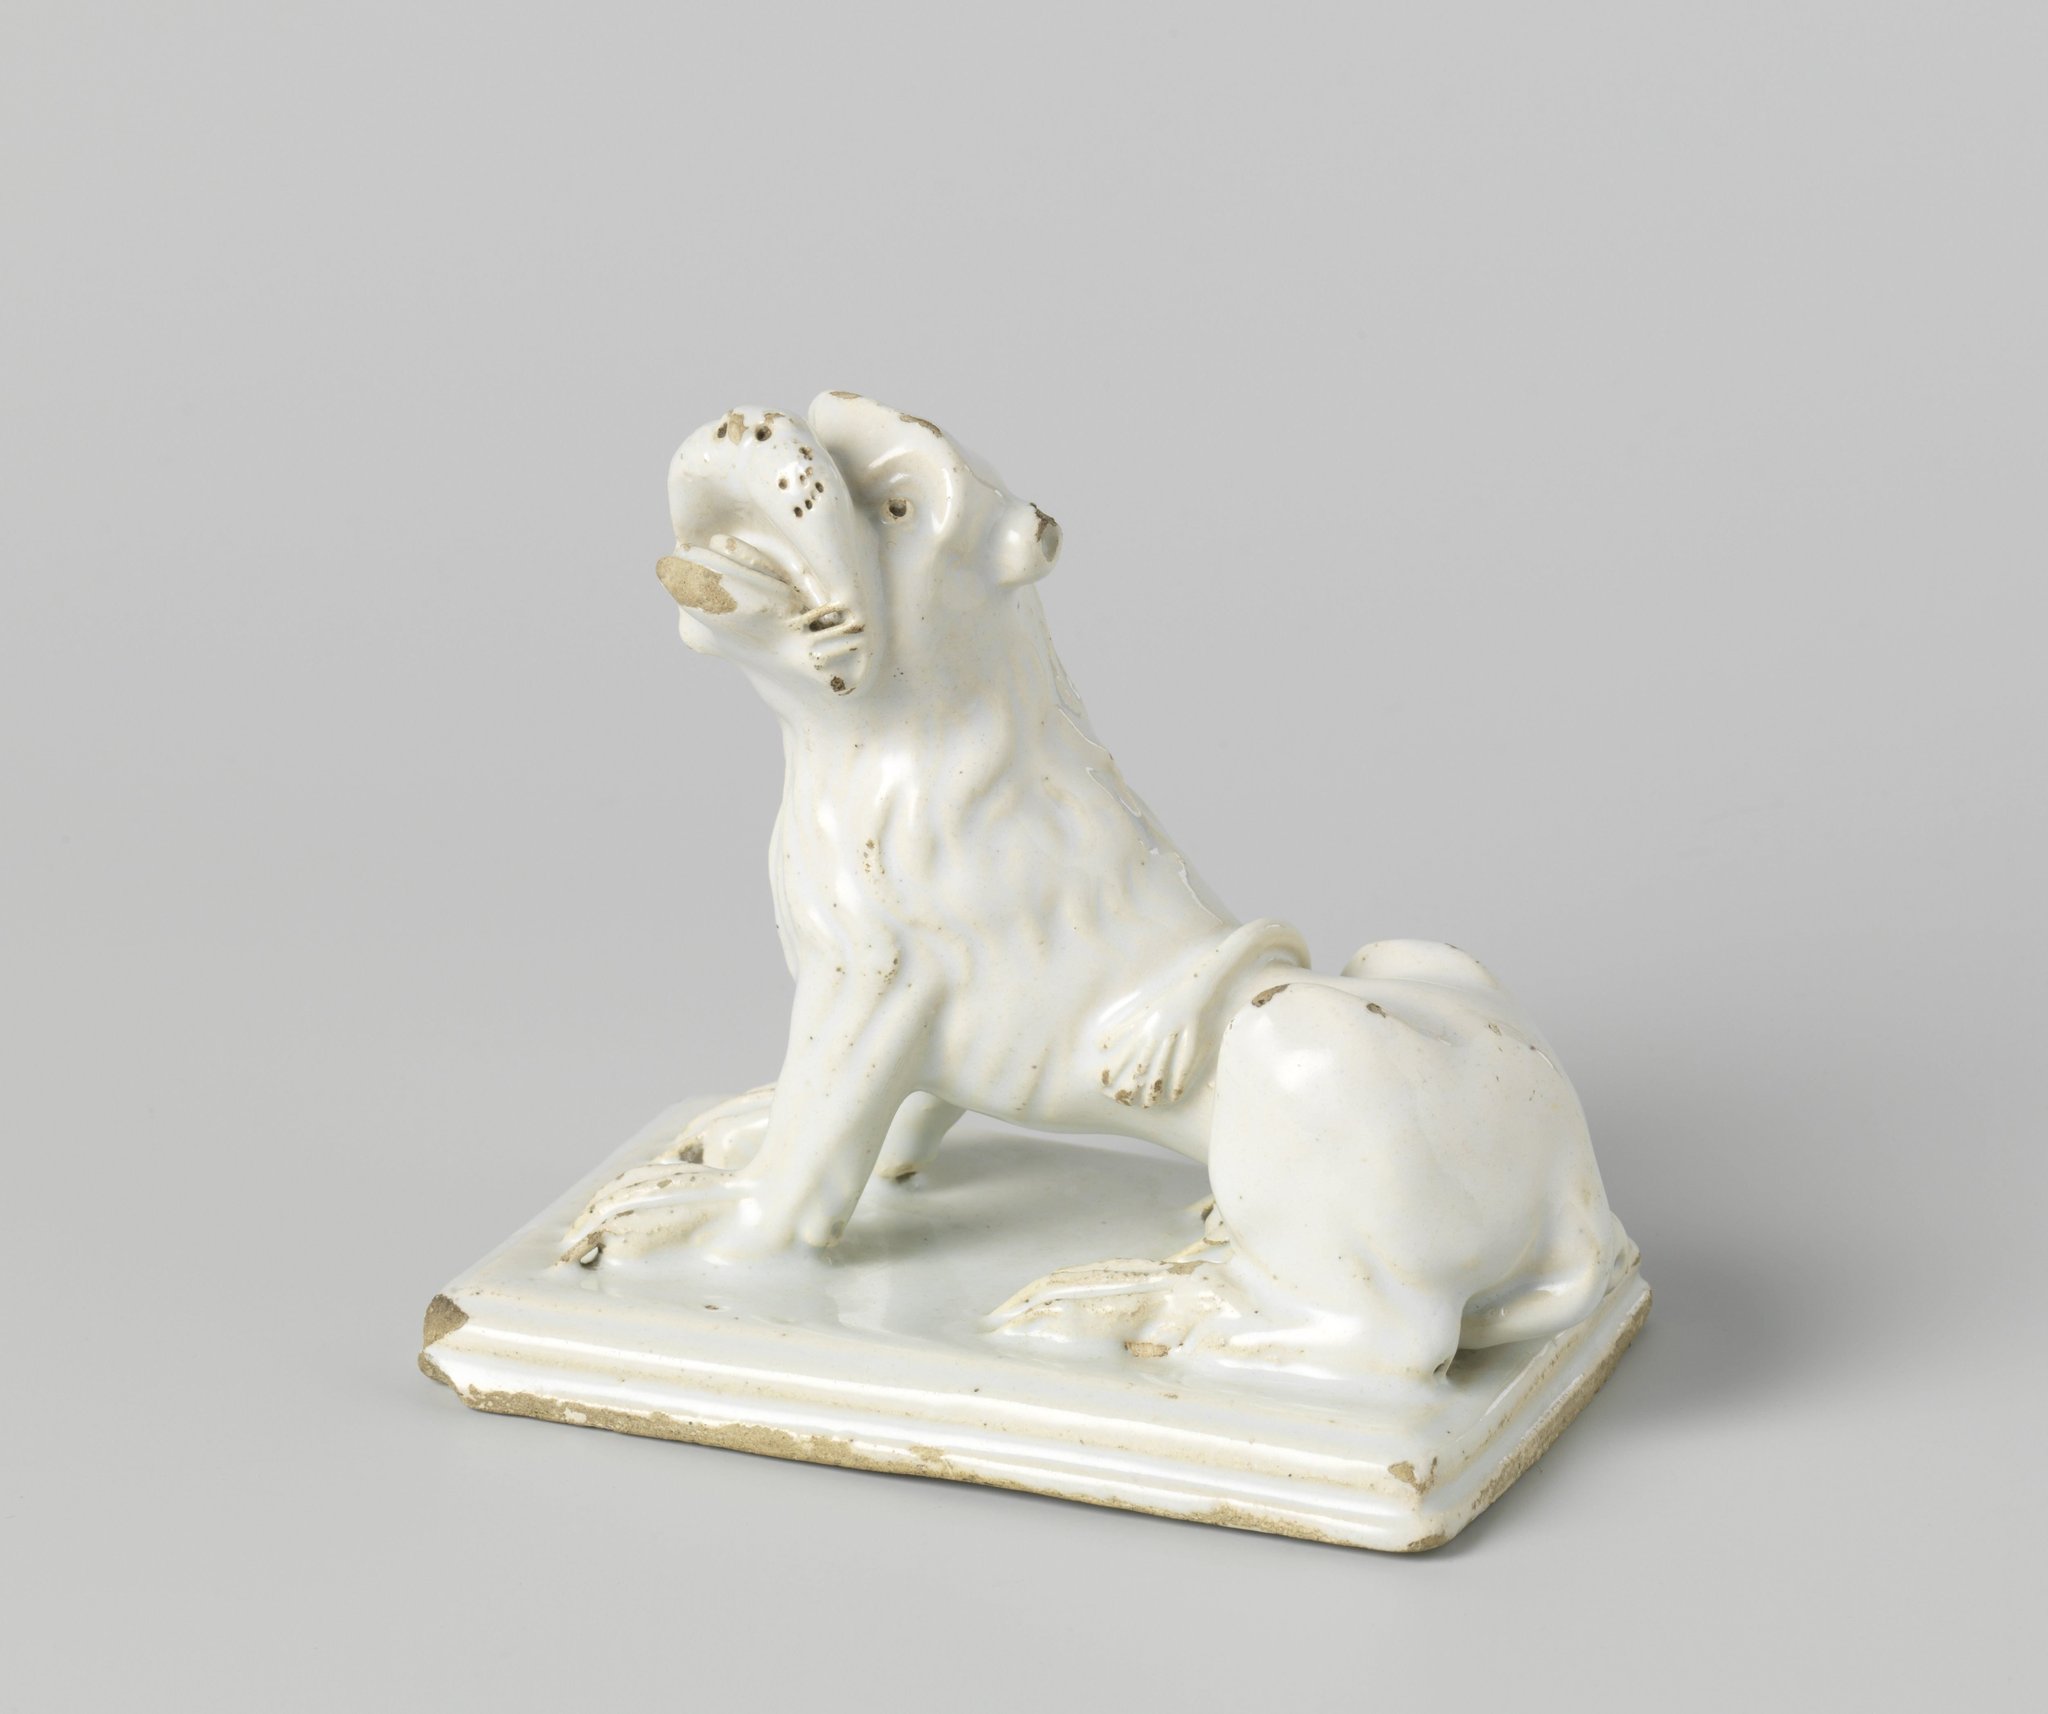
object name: decoratief object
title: Leeuw op rechthoekig geprofileerd voetstuk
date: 1740-1770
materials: earthenware, glaze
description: Beeld van ongedecoreerde faience. Op een rechthoekig geprofileerd voetstuk zit een tempelleeuw met zijn staart over zijn rug geslagen. De leeuw heeft zijn kop naar links gewend.